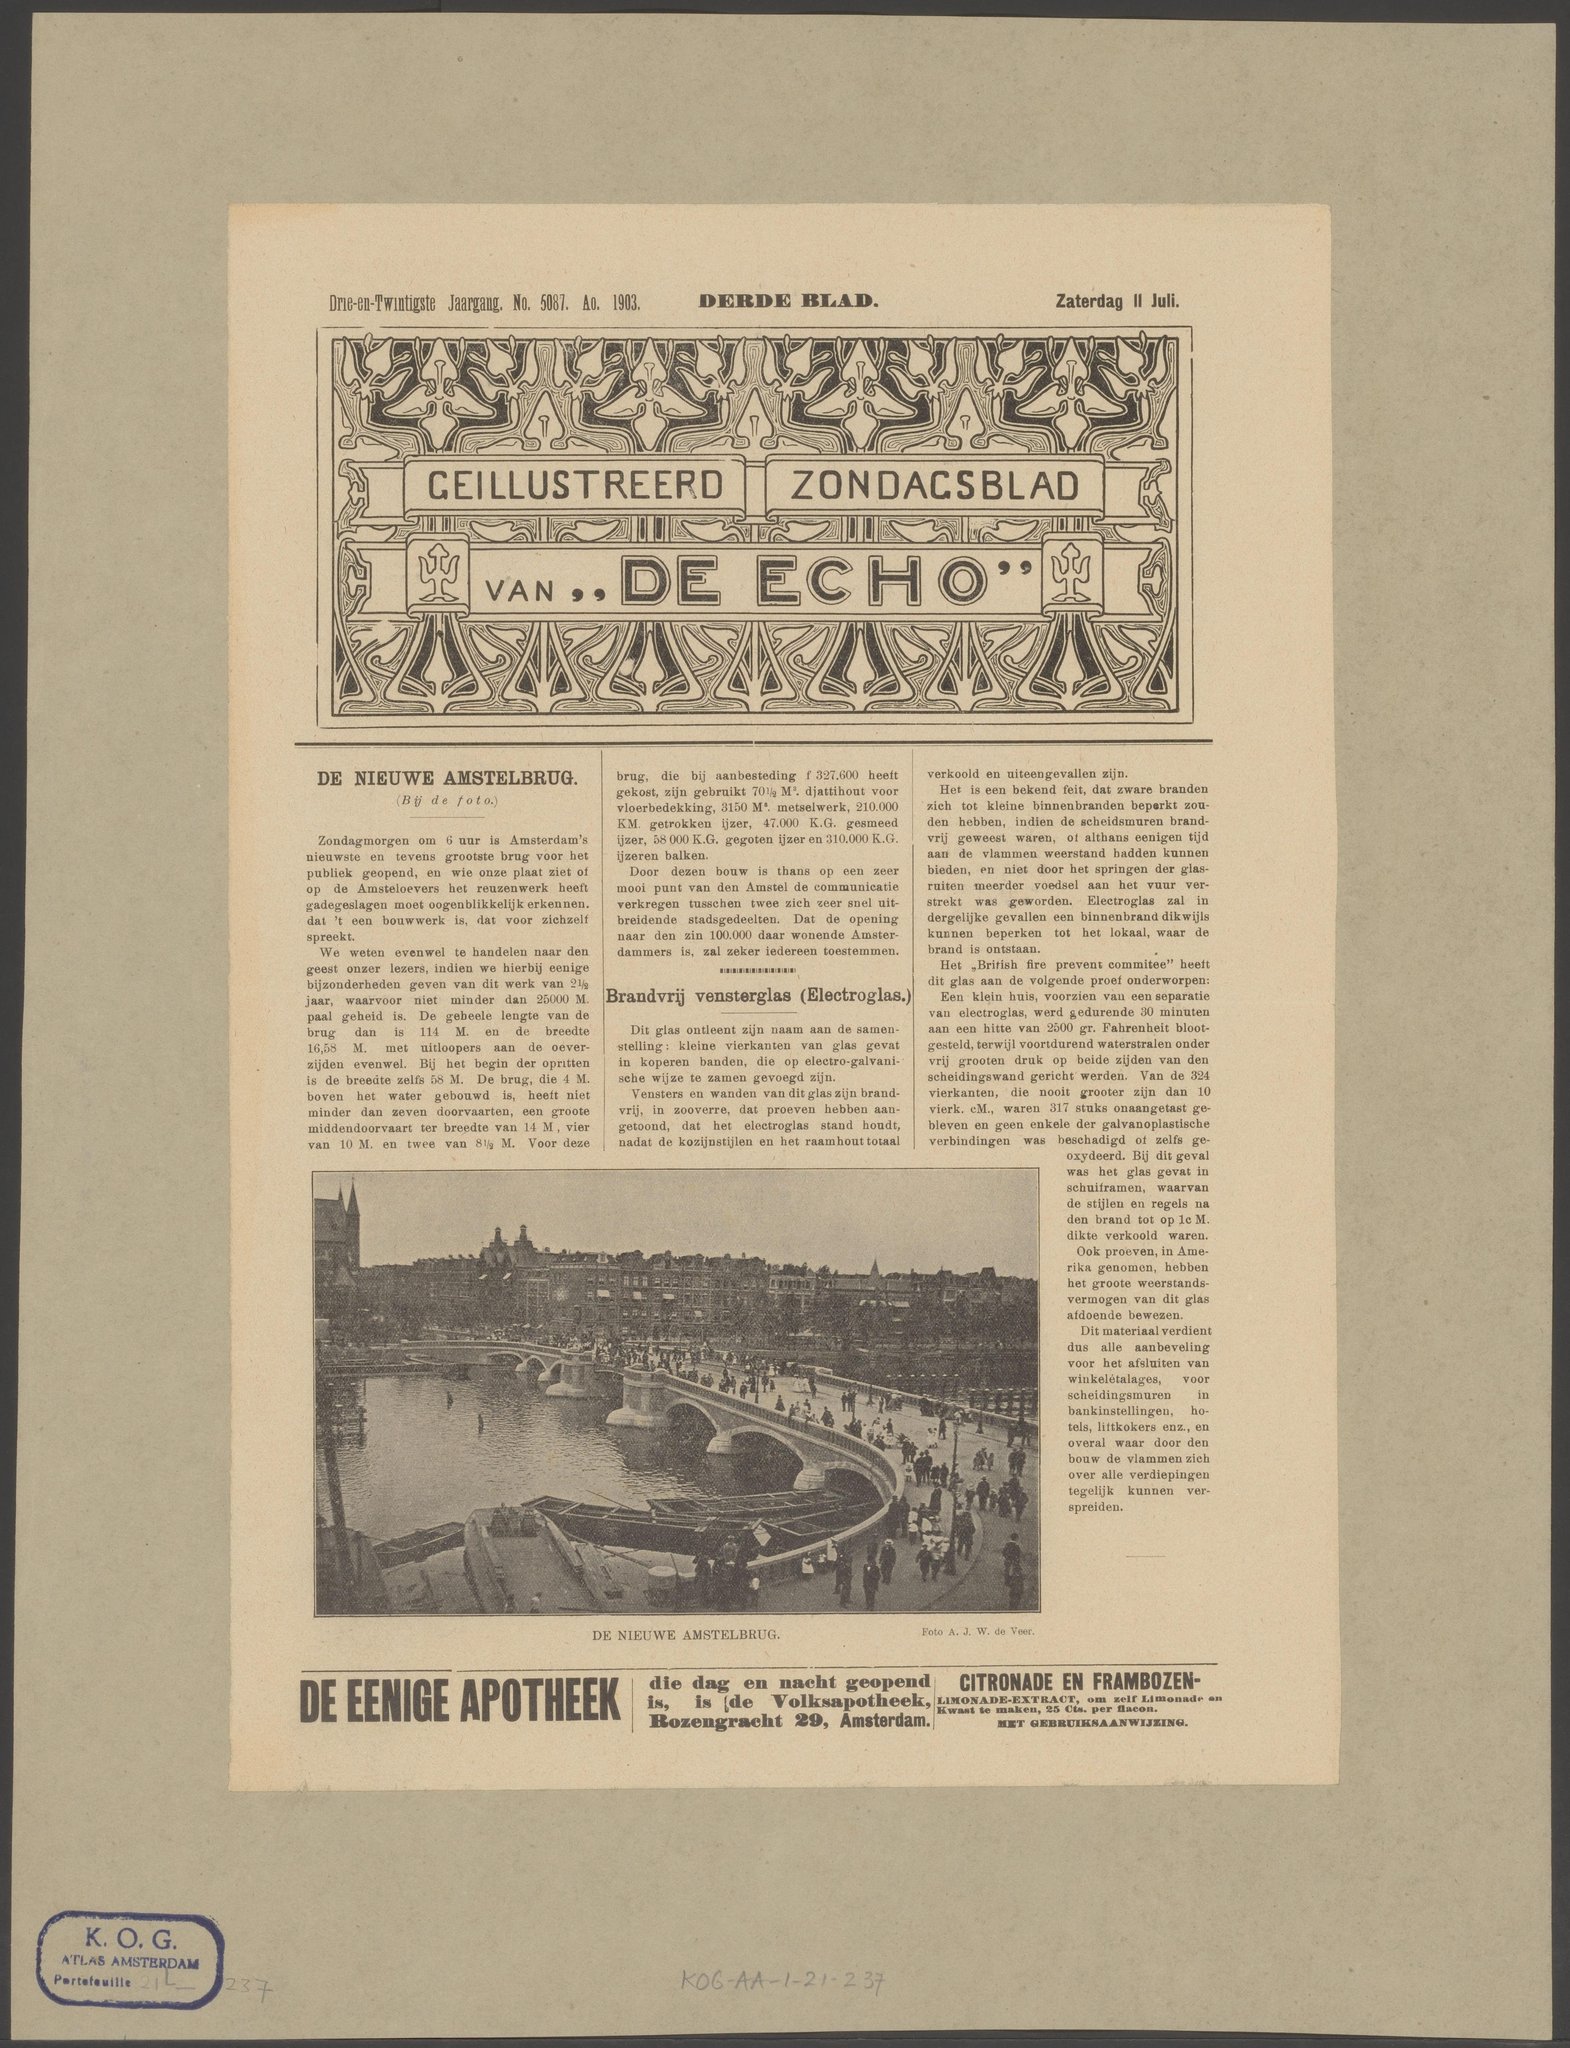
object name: photomechanical print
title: Titelpagina voor: Geïllustreerd Zondagsblad van "De Echo", 11 juli 1903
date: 1903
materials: paper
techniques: letterpress printing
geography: netherlands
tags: city-view, and landscape with man-made constructions, canals, waters (in city), bridge in city across river, canal, etc.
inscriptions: collector's mark: Lugt 1641b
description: Titelpagina voor: Geïllustreerd Zondagsblad van "De Echo" 23 (1903), nr. 5087, 11 juli 1903.